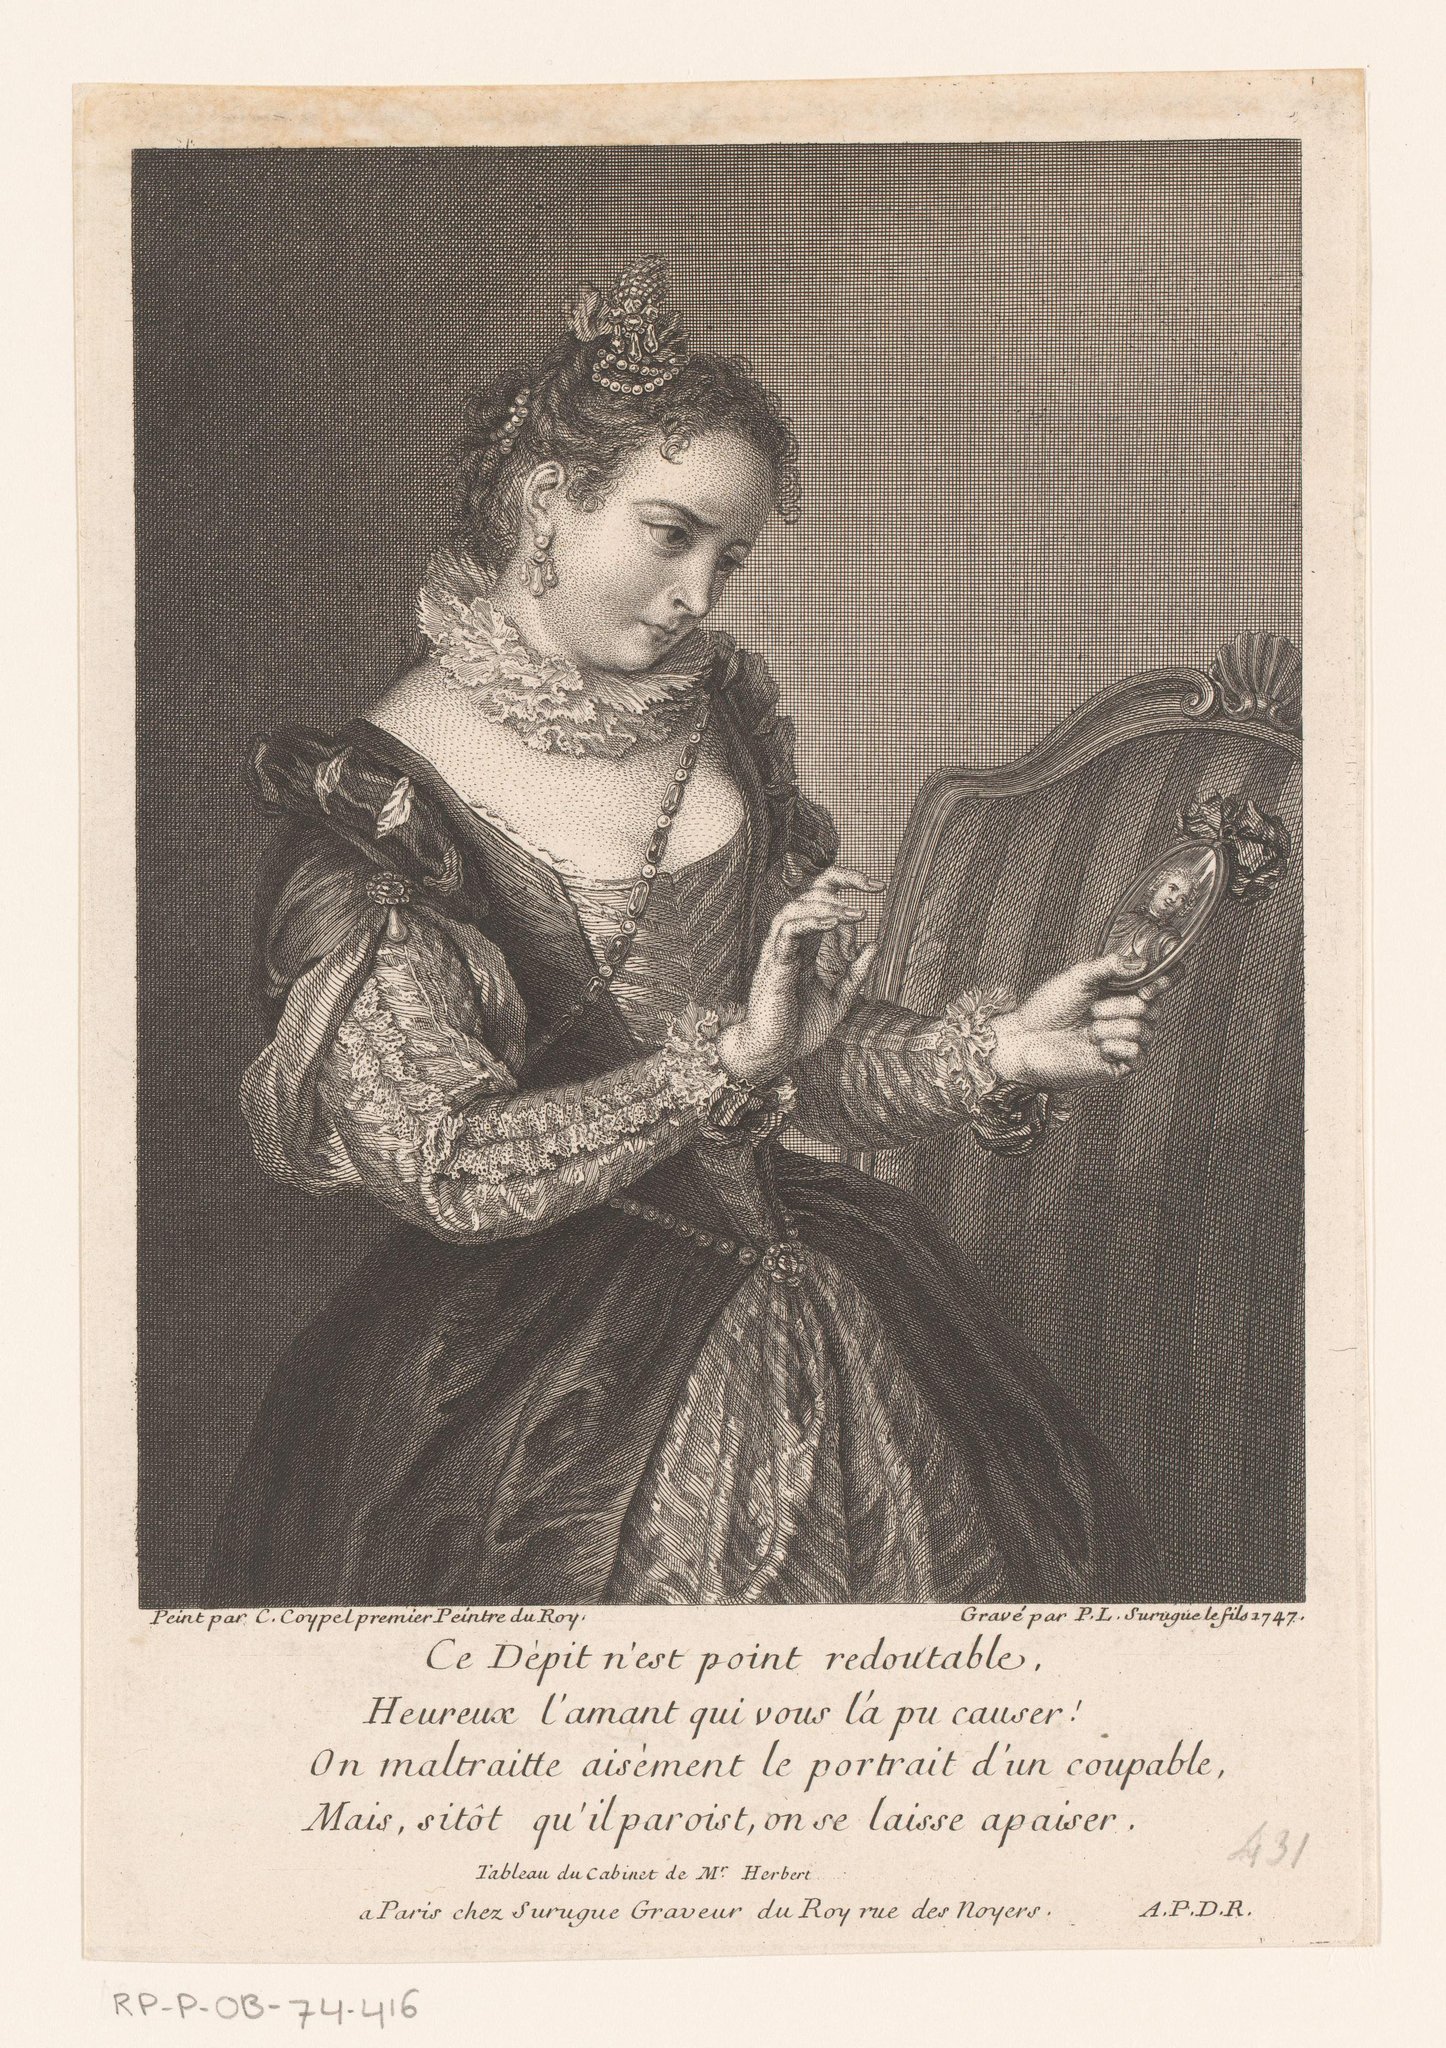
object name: print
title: Dame die het portret van haar geliefde bekijkt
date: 1747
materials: paper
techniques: engraving, etching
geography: france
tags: adult woman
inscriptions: collector's mark: Lugt 240